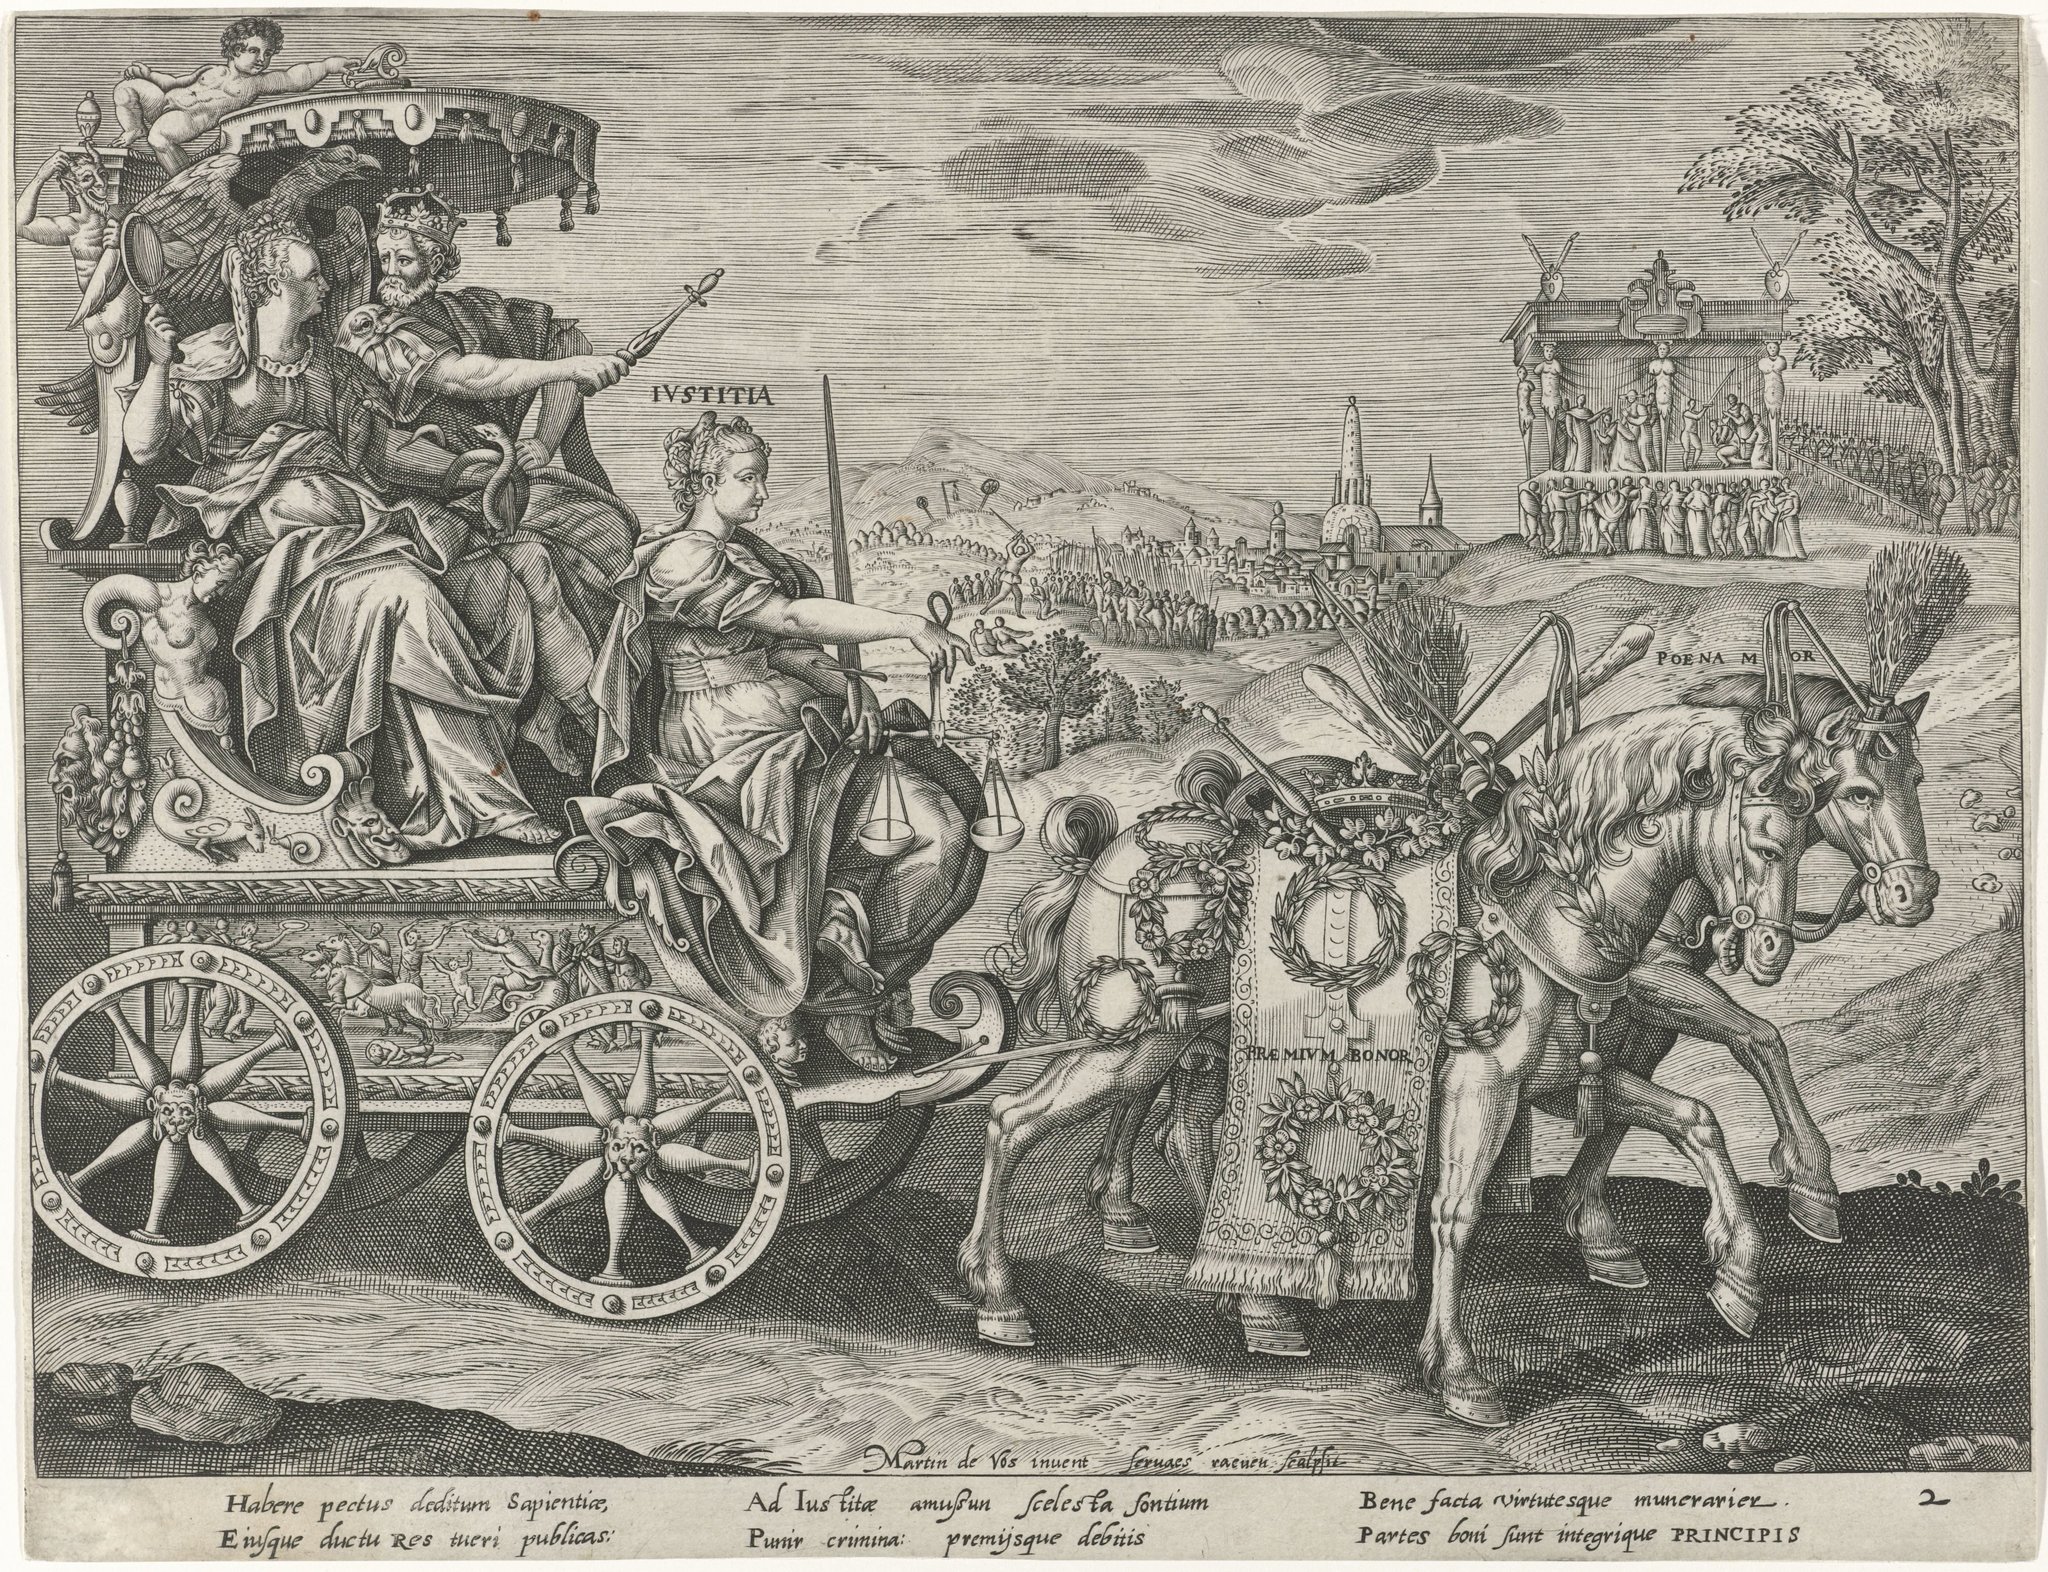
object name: print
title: Wijsheid samen met Justitia en een koning op een triomfwagen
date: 1542-1549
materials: paper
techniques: engraving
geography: netherlands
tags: justice, 'justitia'; 'giustitia divina' (ripa) ~ one of the four cardinal virtues, triumphs (allegorical and symbolic), ruler, sovereign - bb - female ruler, 'sapientia', wisdom; 'sapienza divina' (ripa) ~ one of the seven gifts of the holy ghost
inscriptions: collector's mark: Lugt 2228, collector's mark: Lugt 2760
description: Op een triomfwagen worden een koning en de personificatie van de Wijsheid (met spiegel en slang), begeleid door Justitia (met zwaard en weegschaal), rondgereden. Voor de wagen twee paarden, waarvan er een wapens op de rug heeft en de ander lauwerkransen, een kroon en een regeerderstaf. Op de achtergrond een landschap met soldaten en een podium waar een figuur tot ridder wordt geslagen.